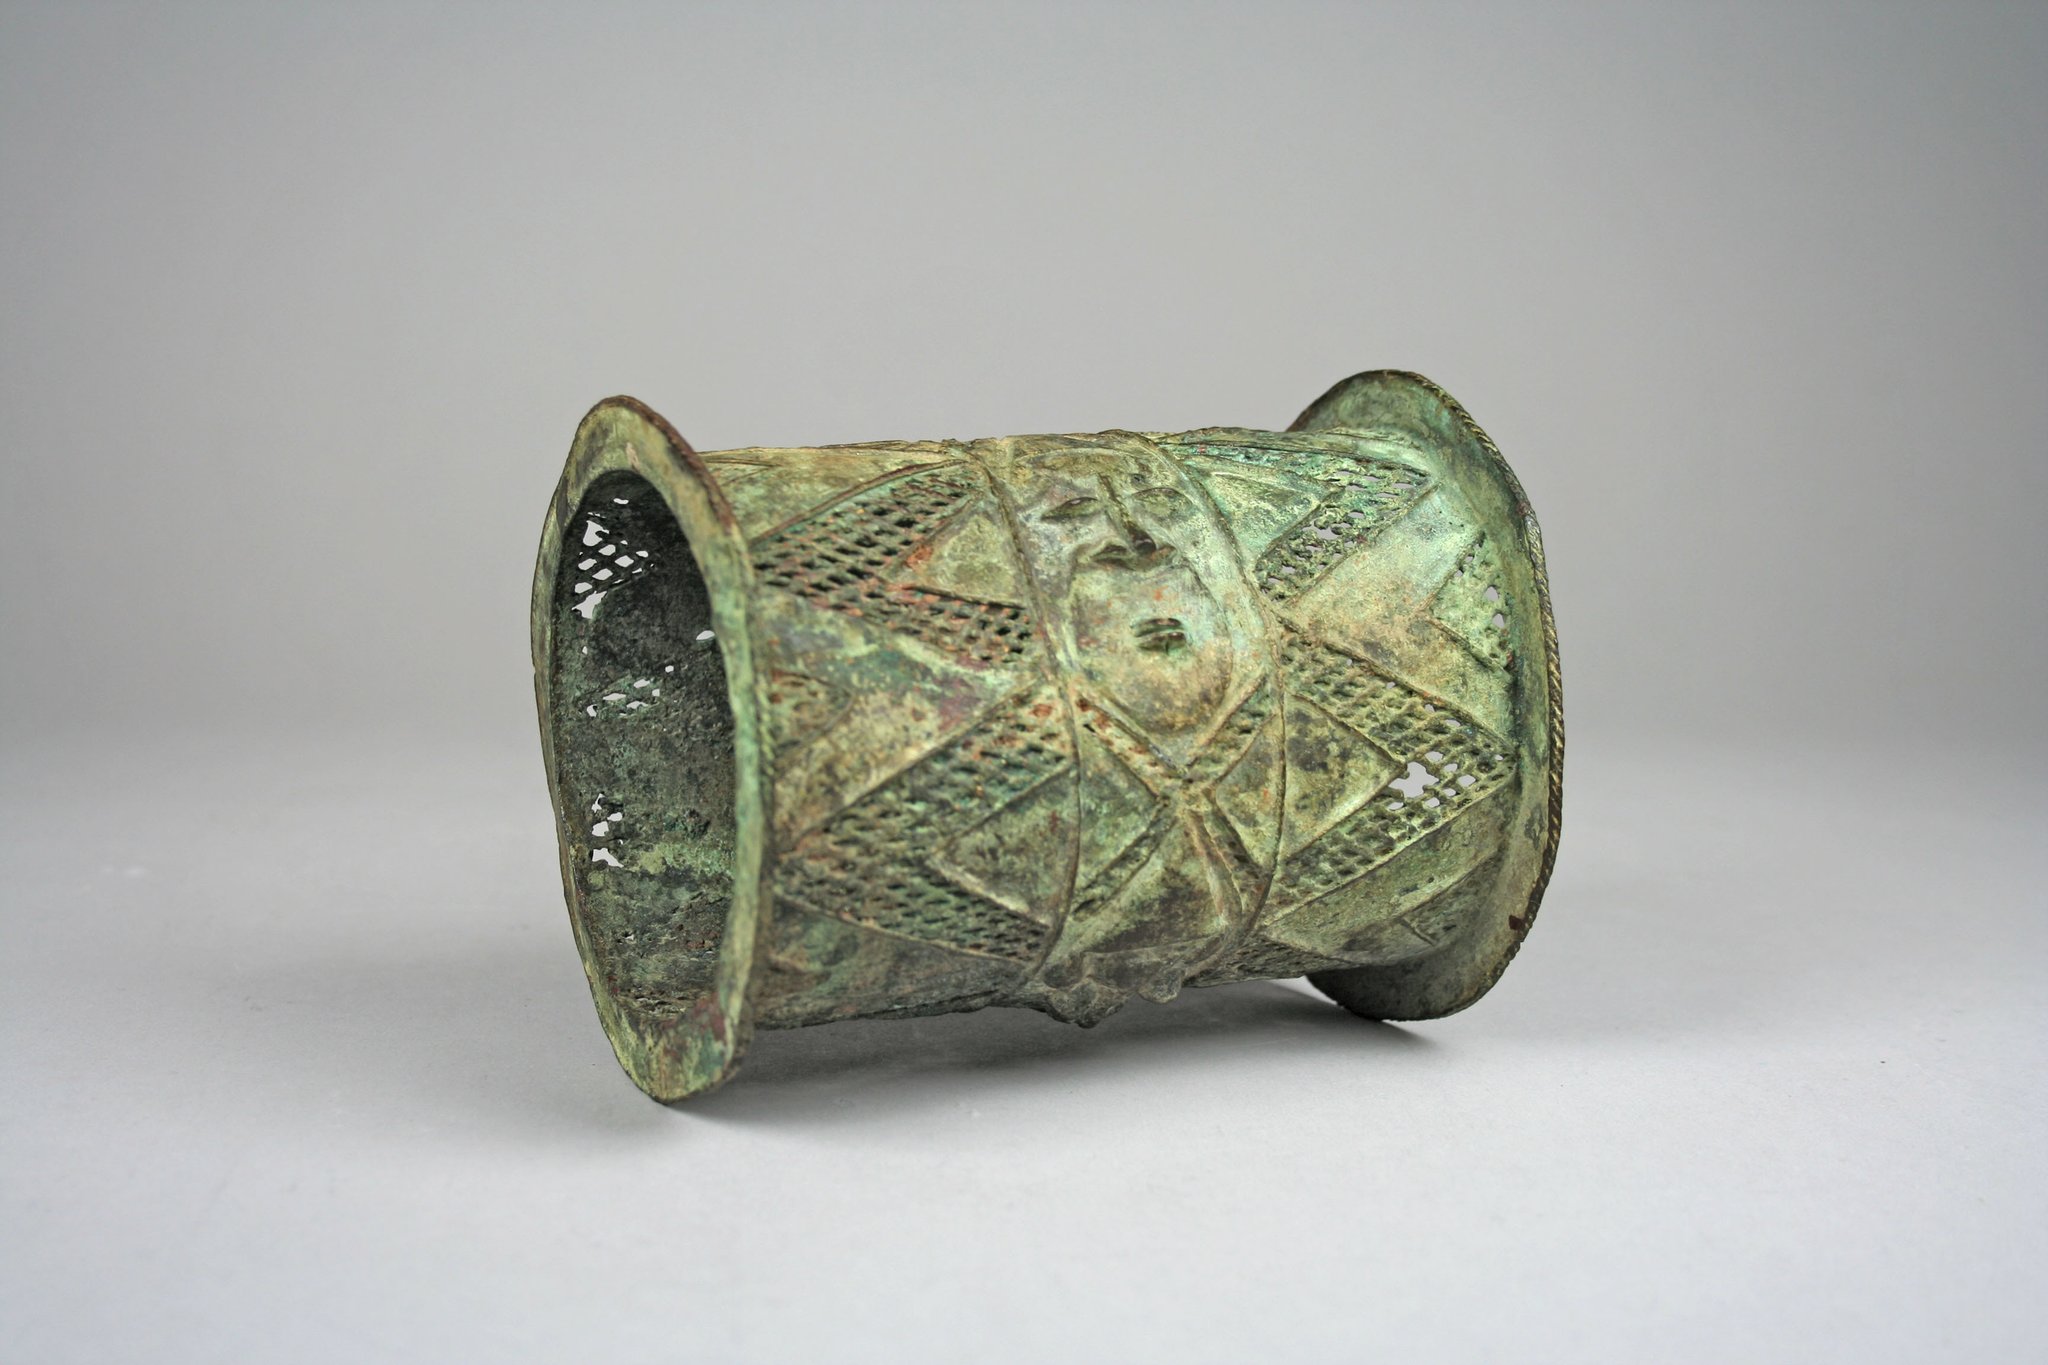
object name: bracelet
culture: yoruba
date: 1401-1900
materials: bronze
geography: nigeria